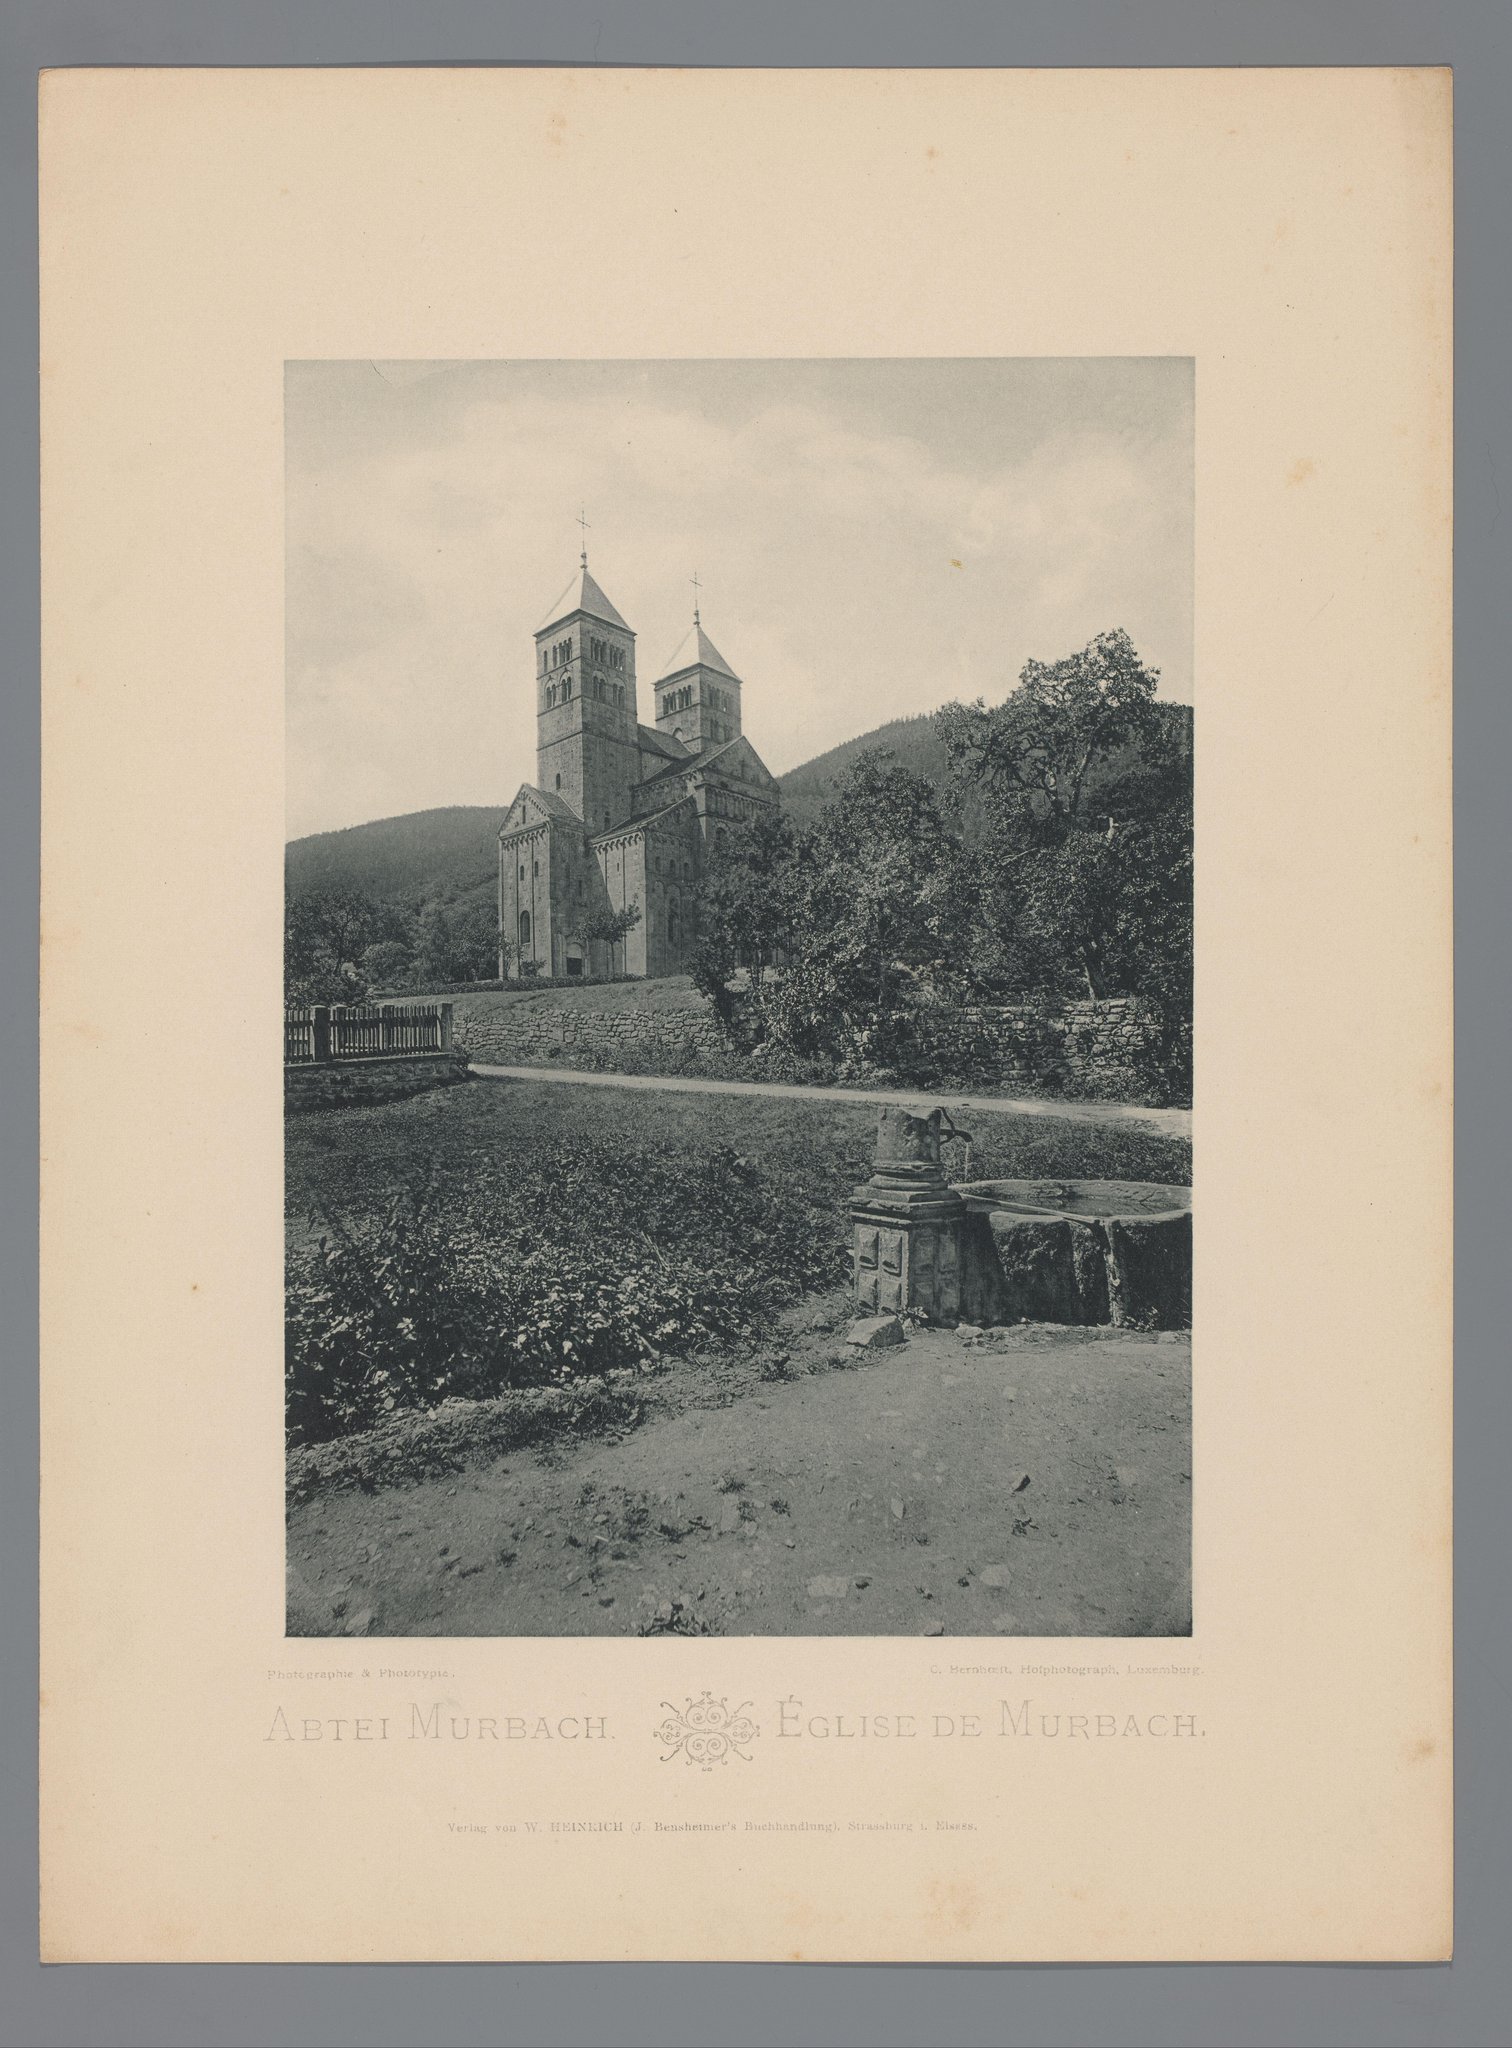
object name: page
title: Gezicht op de abdij van Murbach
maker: charles bernhoeft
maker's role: publisher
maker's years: 1859-1933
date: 1889-1894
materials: paper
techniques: photograph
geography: murbach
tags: abbey, monastery, convent ~ roman catholic church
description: Deze prent maakt deel uit van een omslag met 100 prenten.